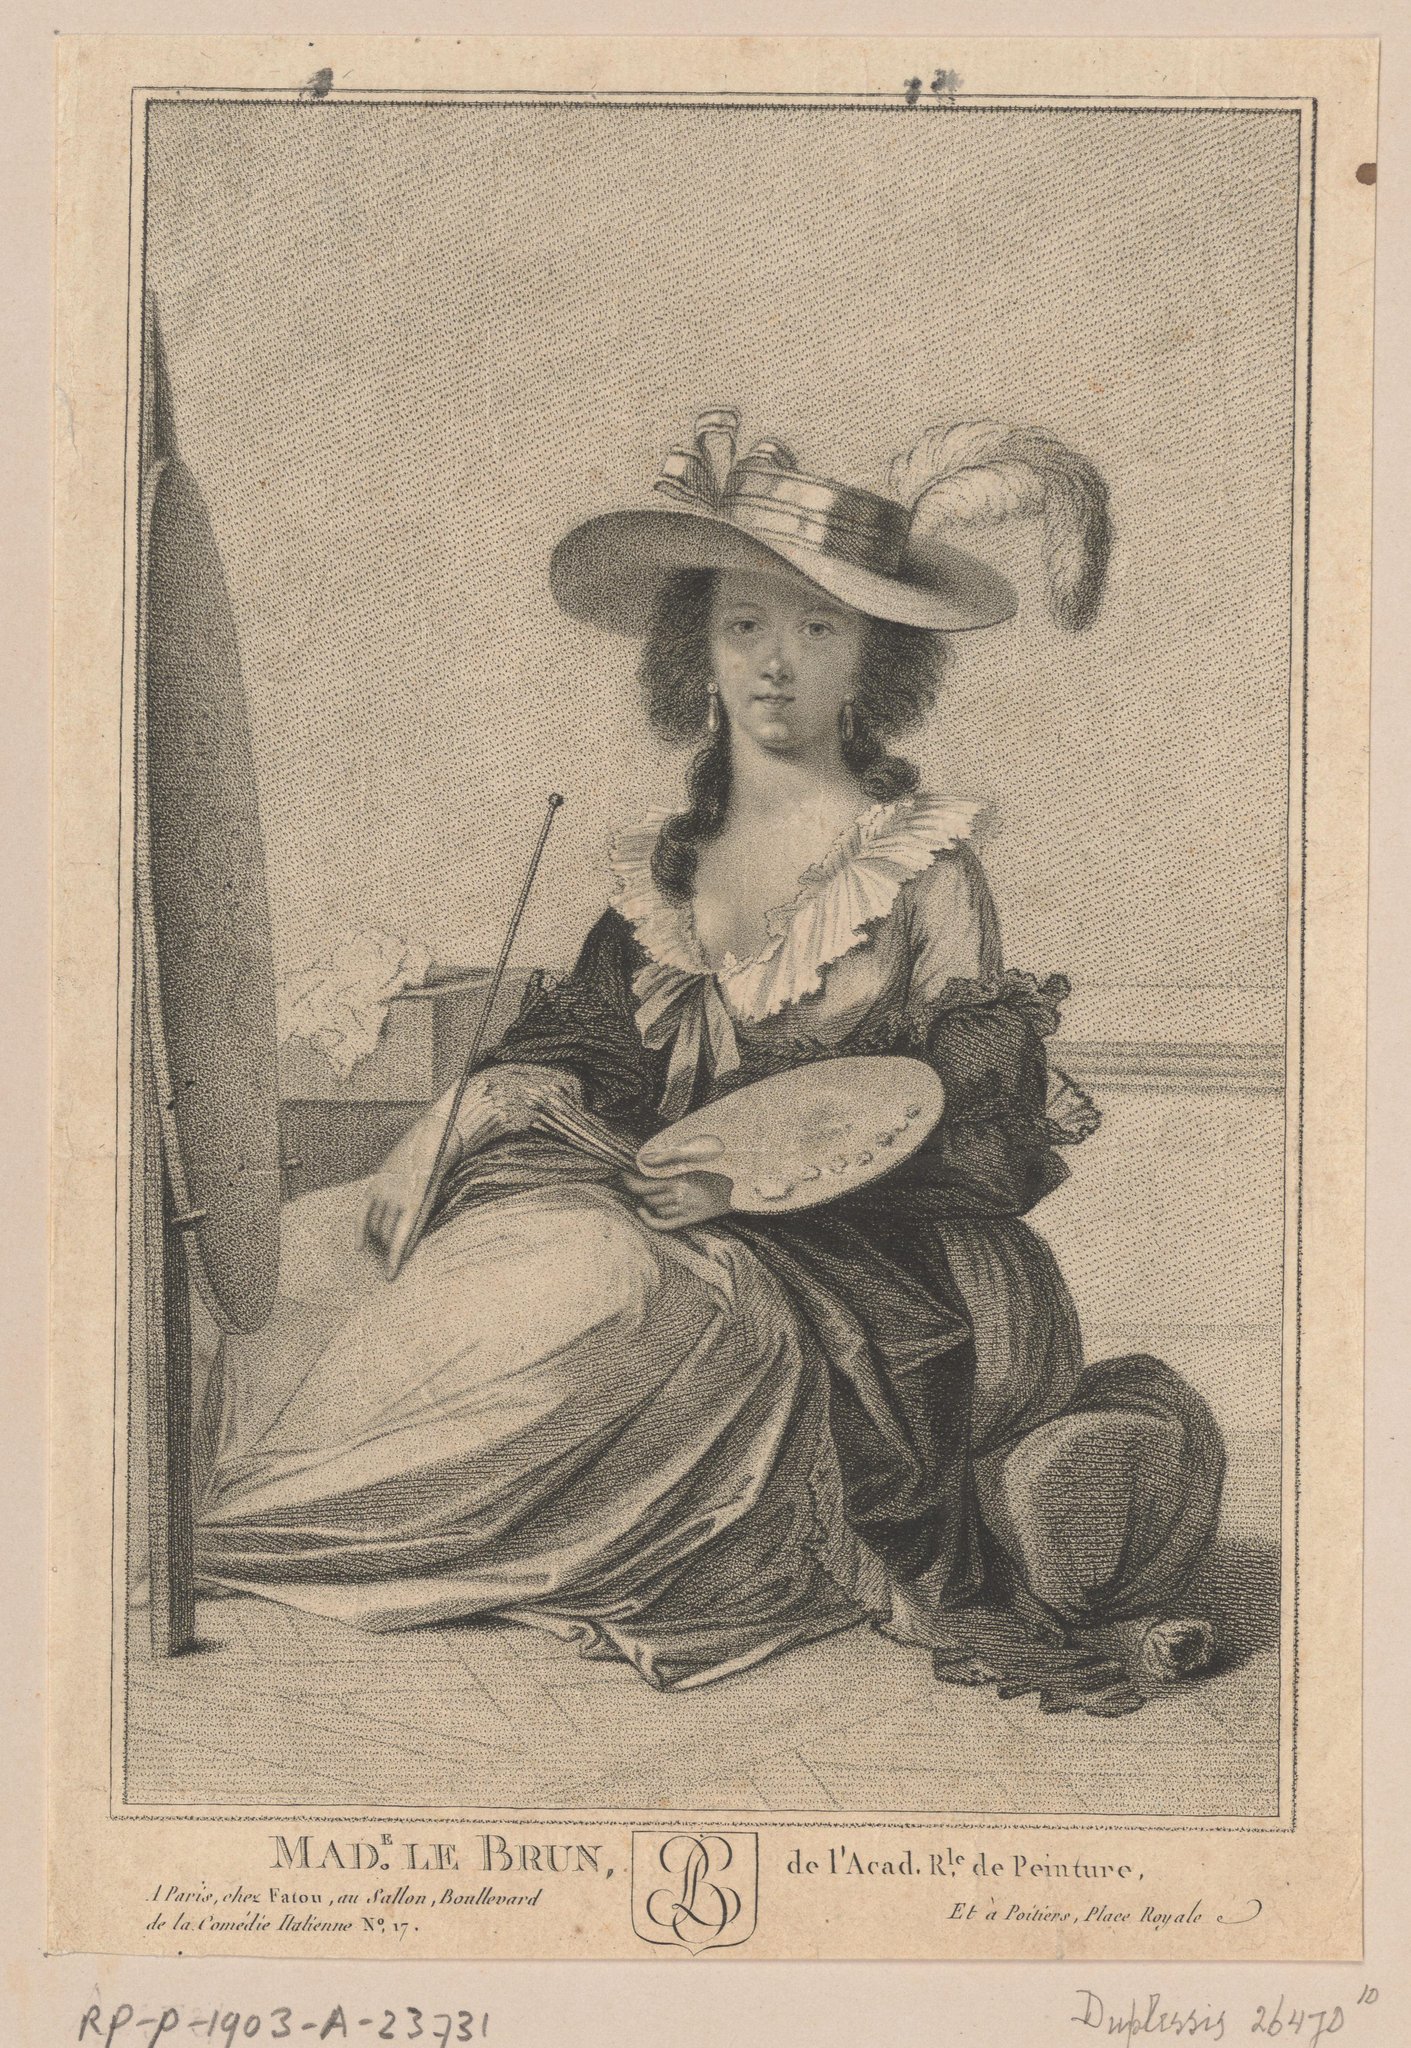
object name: print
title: Portret van Elisabeth Vigée-Le Brun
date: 1800-1899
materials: paper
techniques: lithograph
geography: france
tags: paris, elisabeth vigée-le brun, historical persons - bb - woman, portrait, self-portrait of painter, palette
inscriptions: collector's mark: Lugt 2228